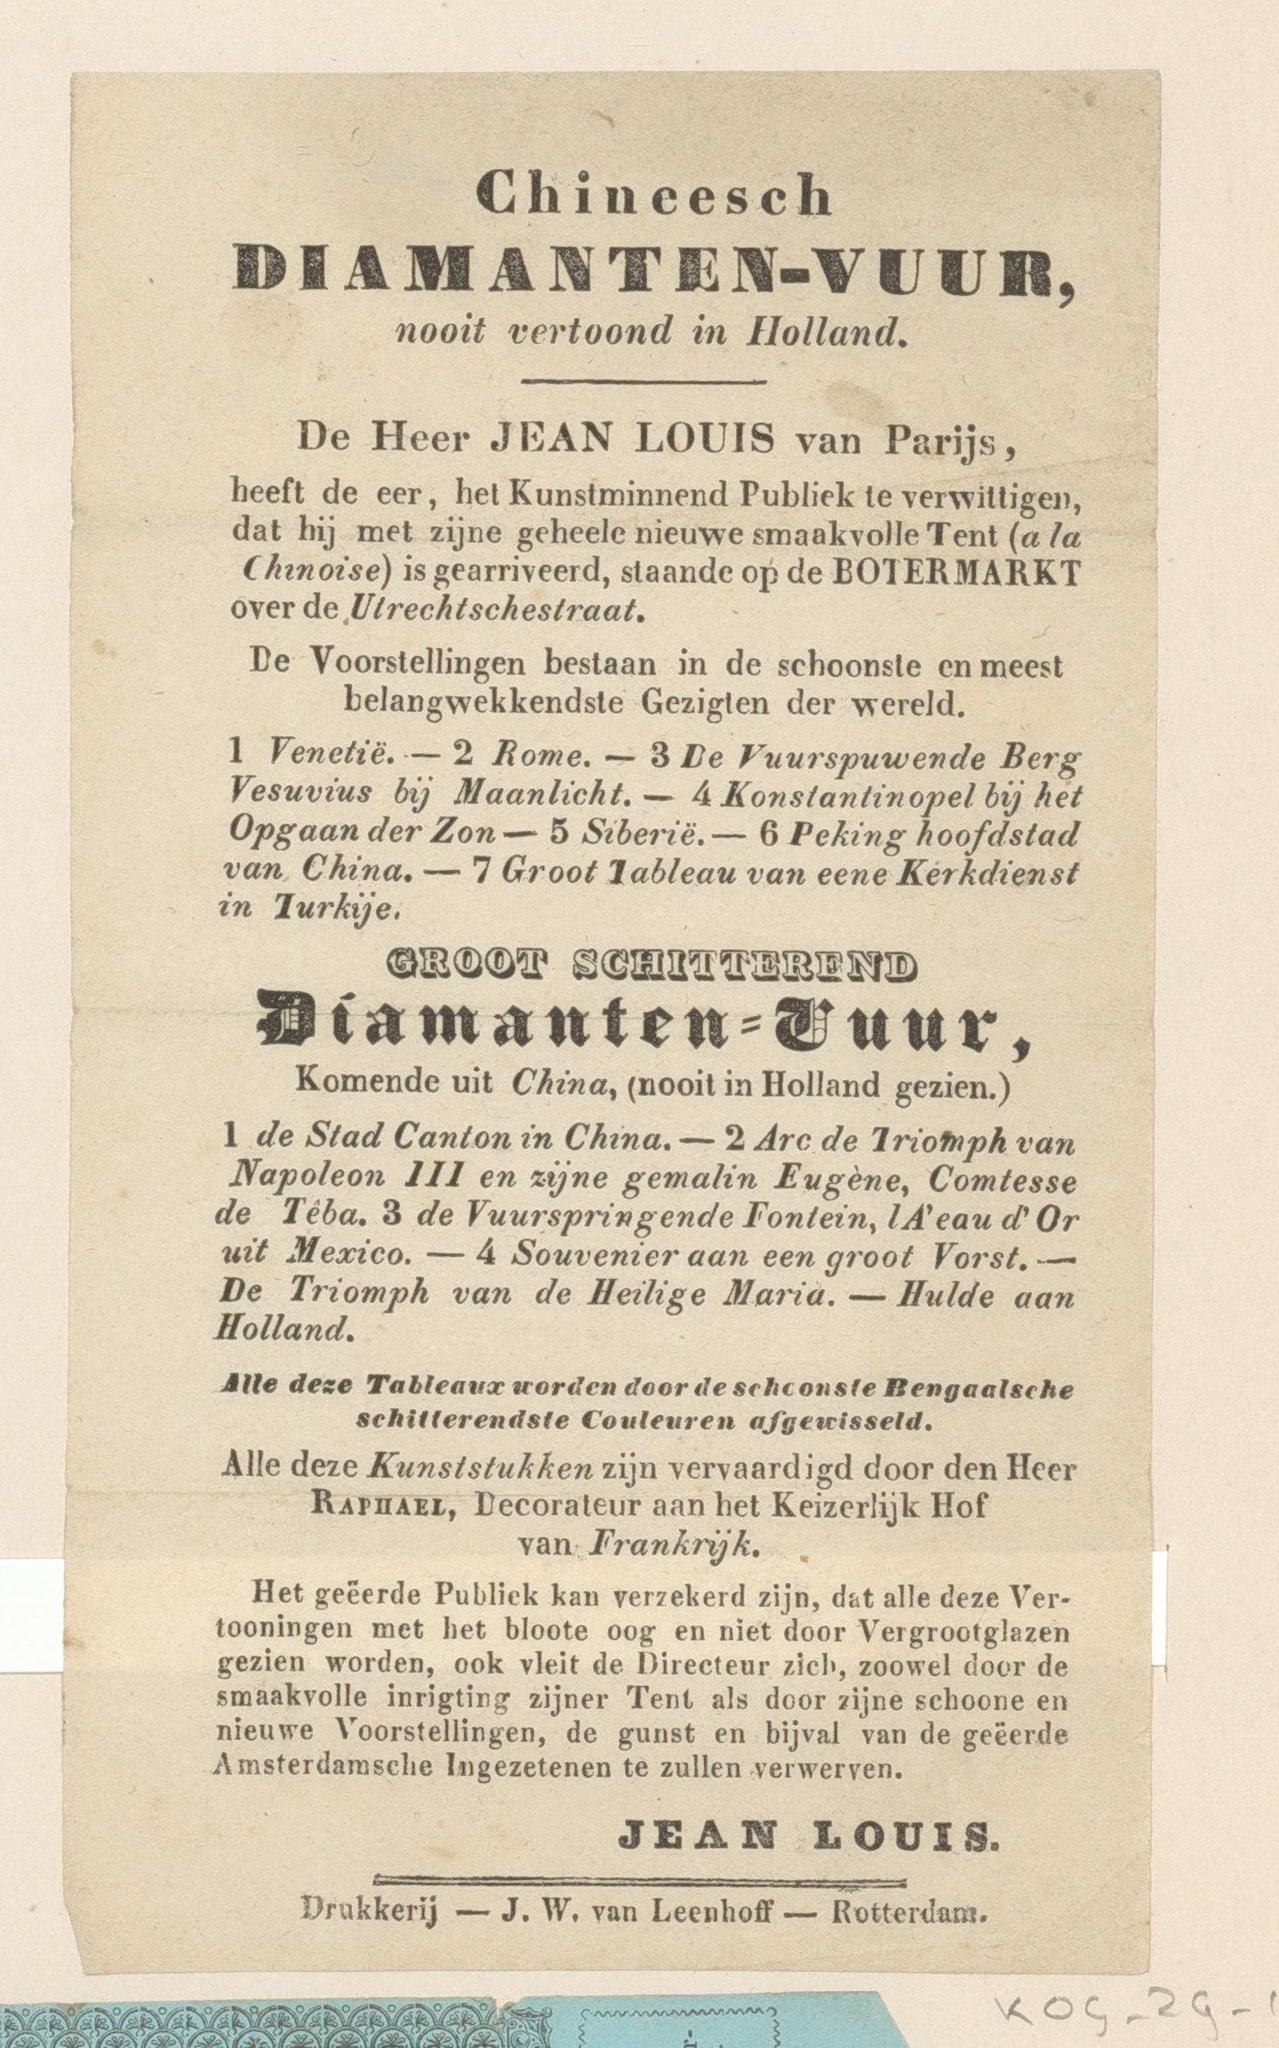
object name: reclamebiljet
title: Chineesch Diamanten-Vuur, nooit vertoond in Holland. De heer Jean Louis van Parijs, heeft de eer (...) op de Botermarkt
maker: leenhoff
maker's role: printer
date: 1855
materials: paper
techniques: letterpress printing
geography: rotterdam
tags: panorama, cyclorama, pleasure fair and circus, bonfire, fire-works, amsterdam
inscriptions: collector's mark: Lugt 1641, collector's mark